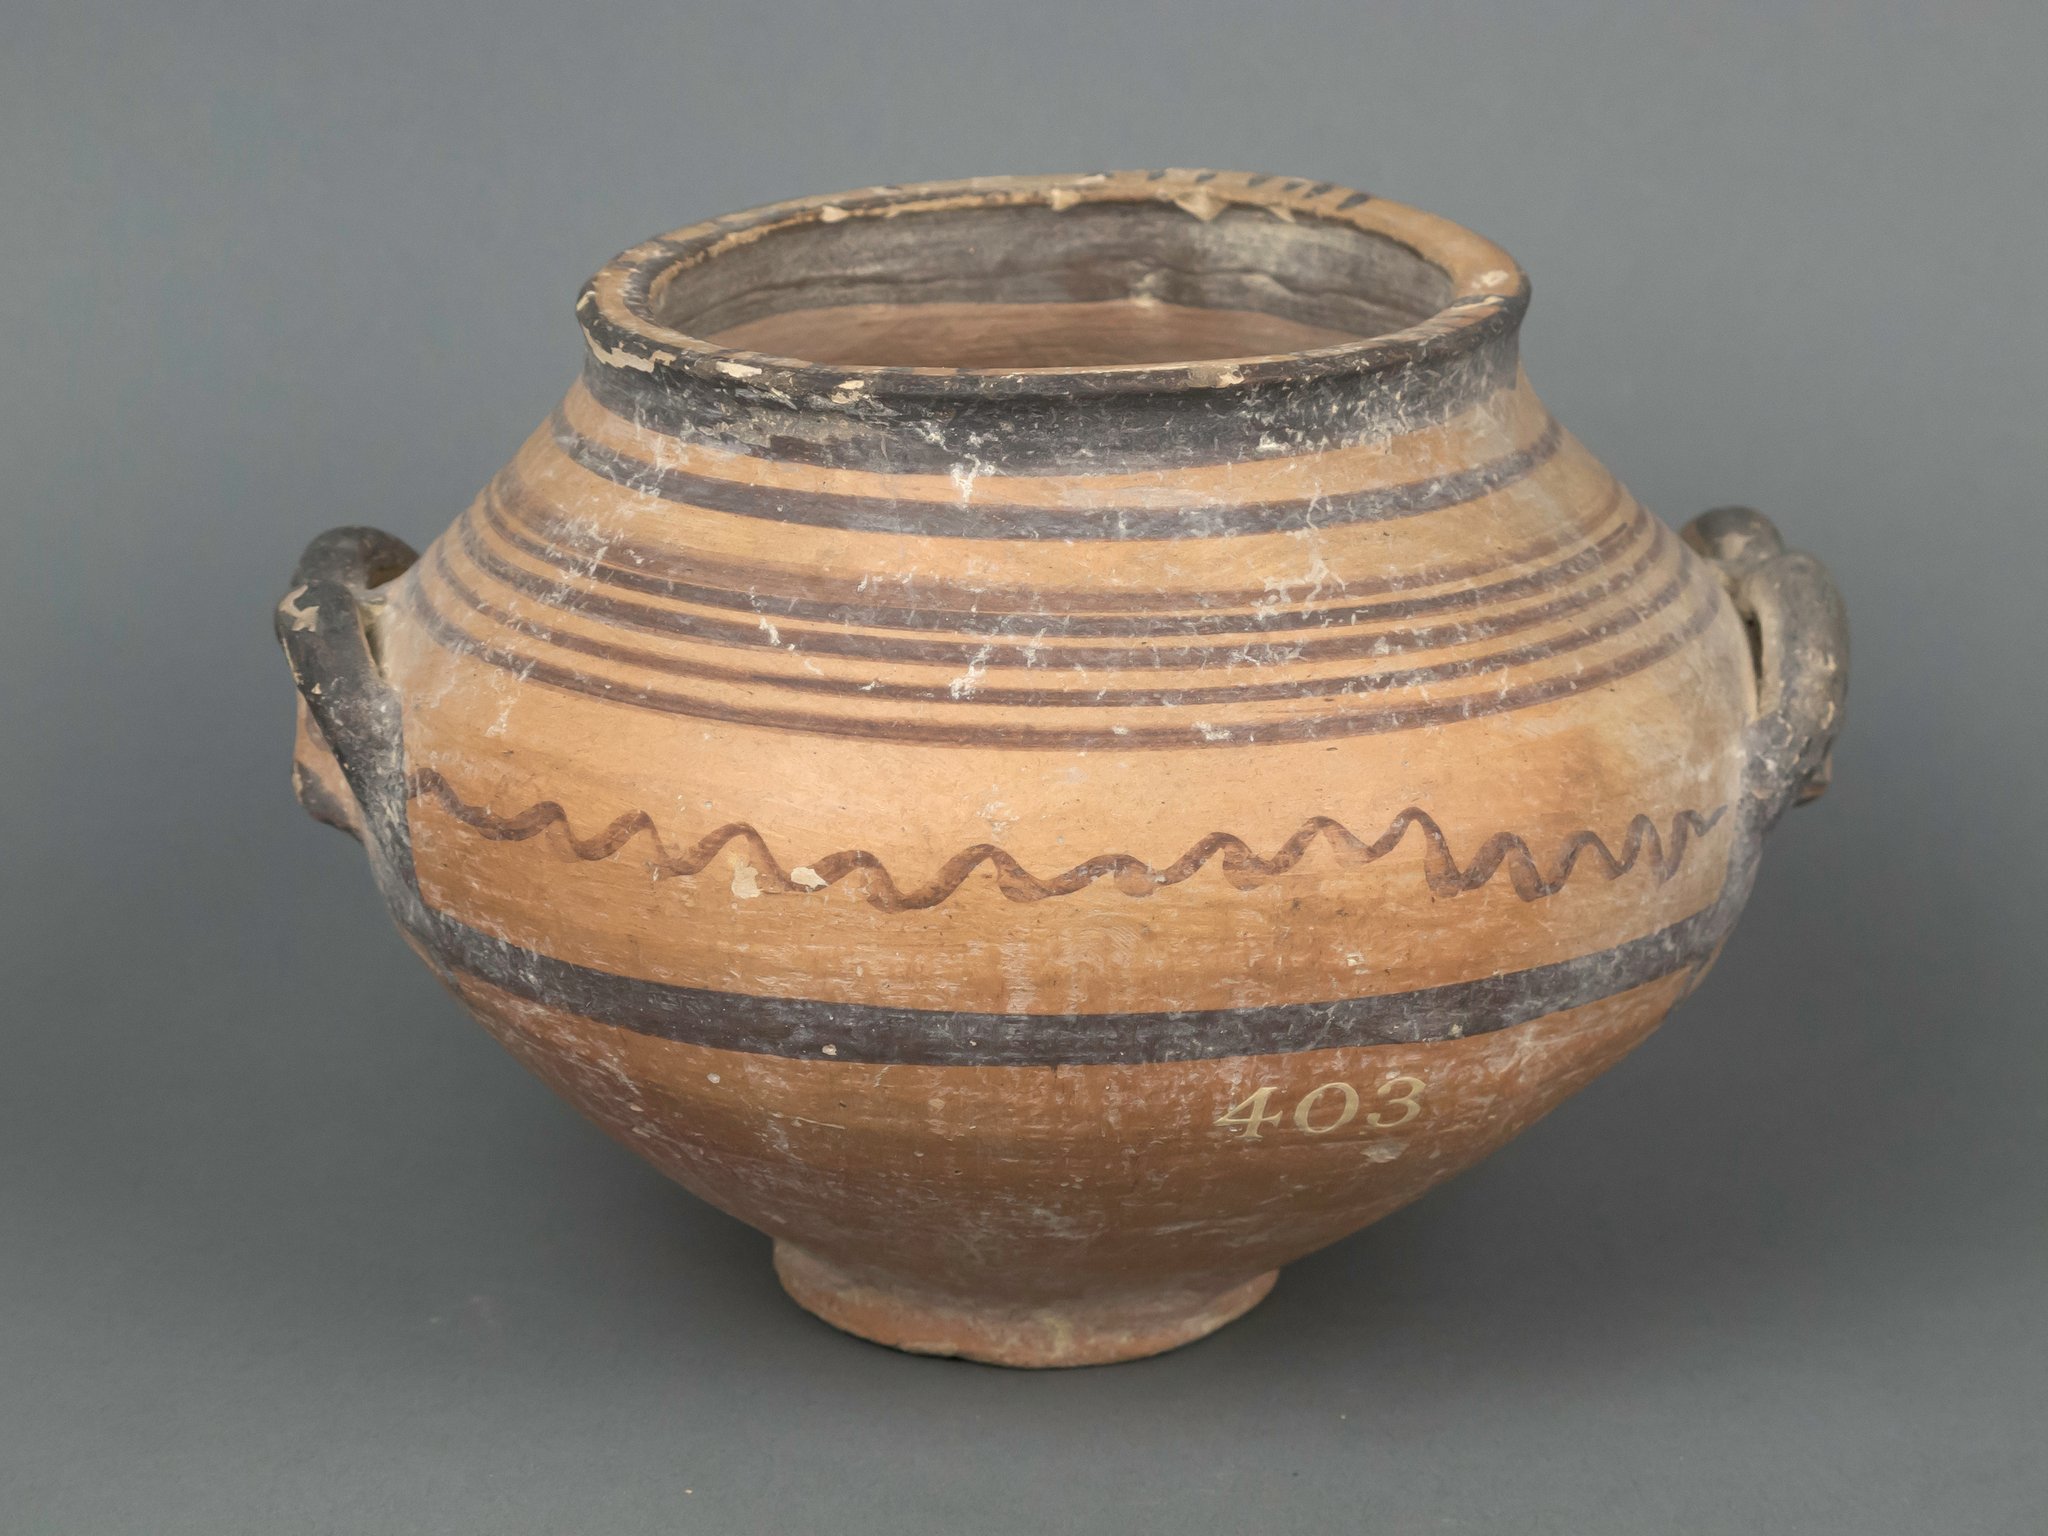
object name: bowl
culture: cypriot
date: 850-750 BCE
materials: terracotta